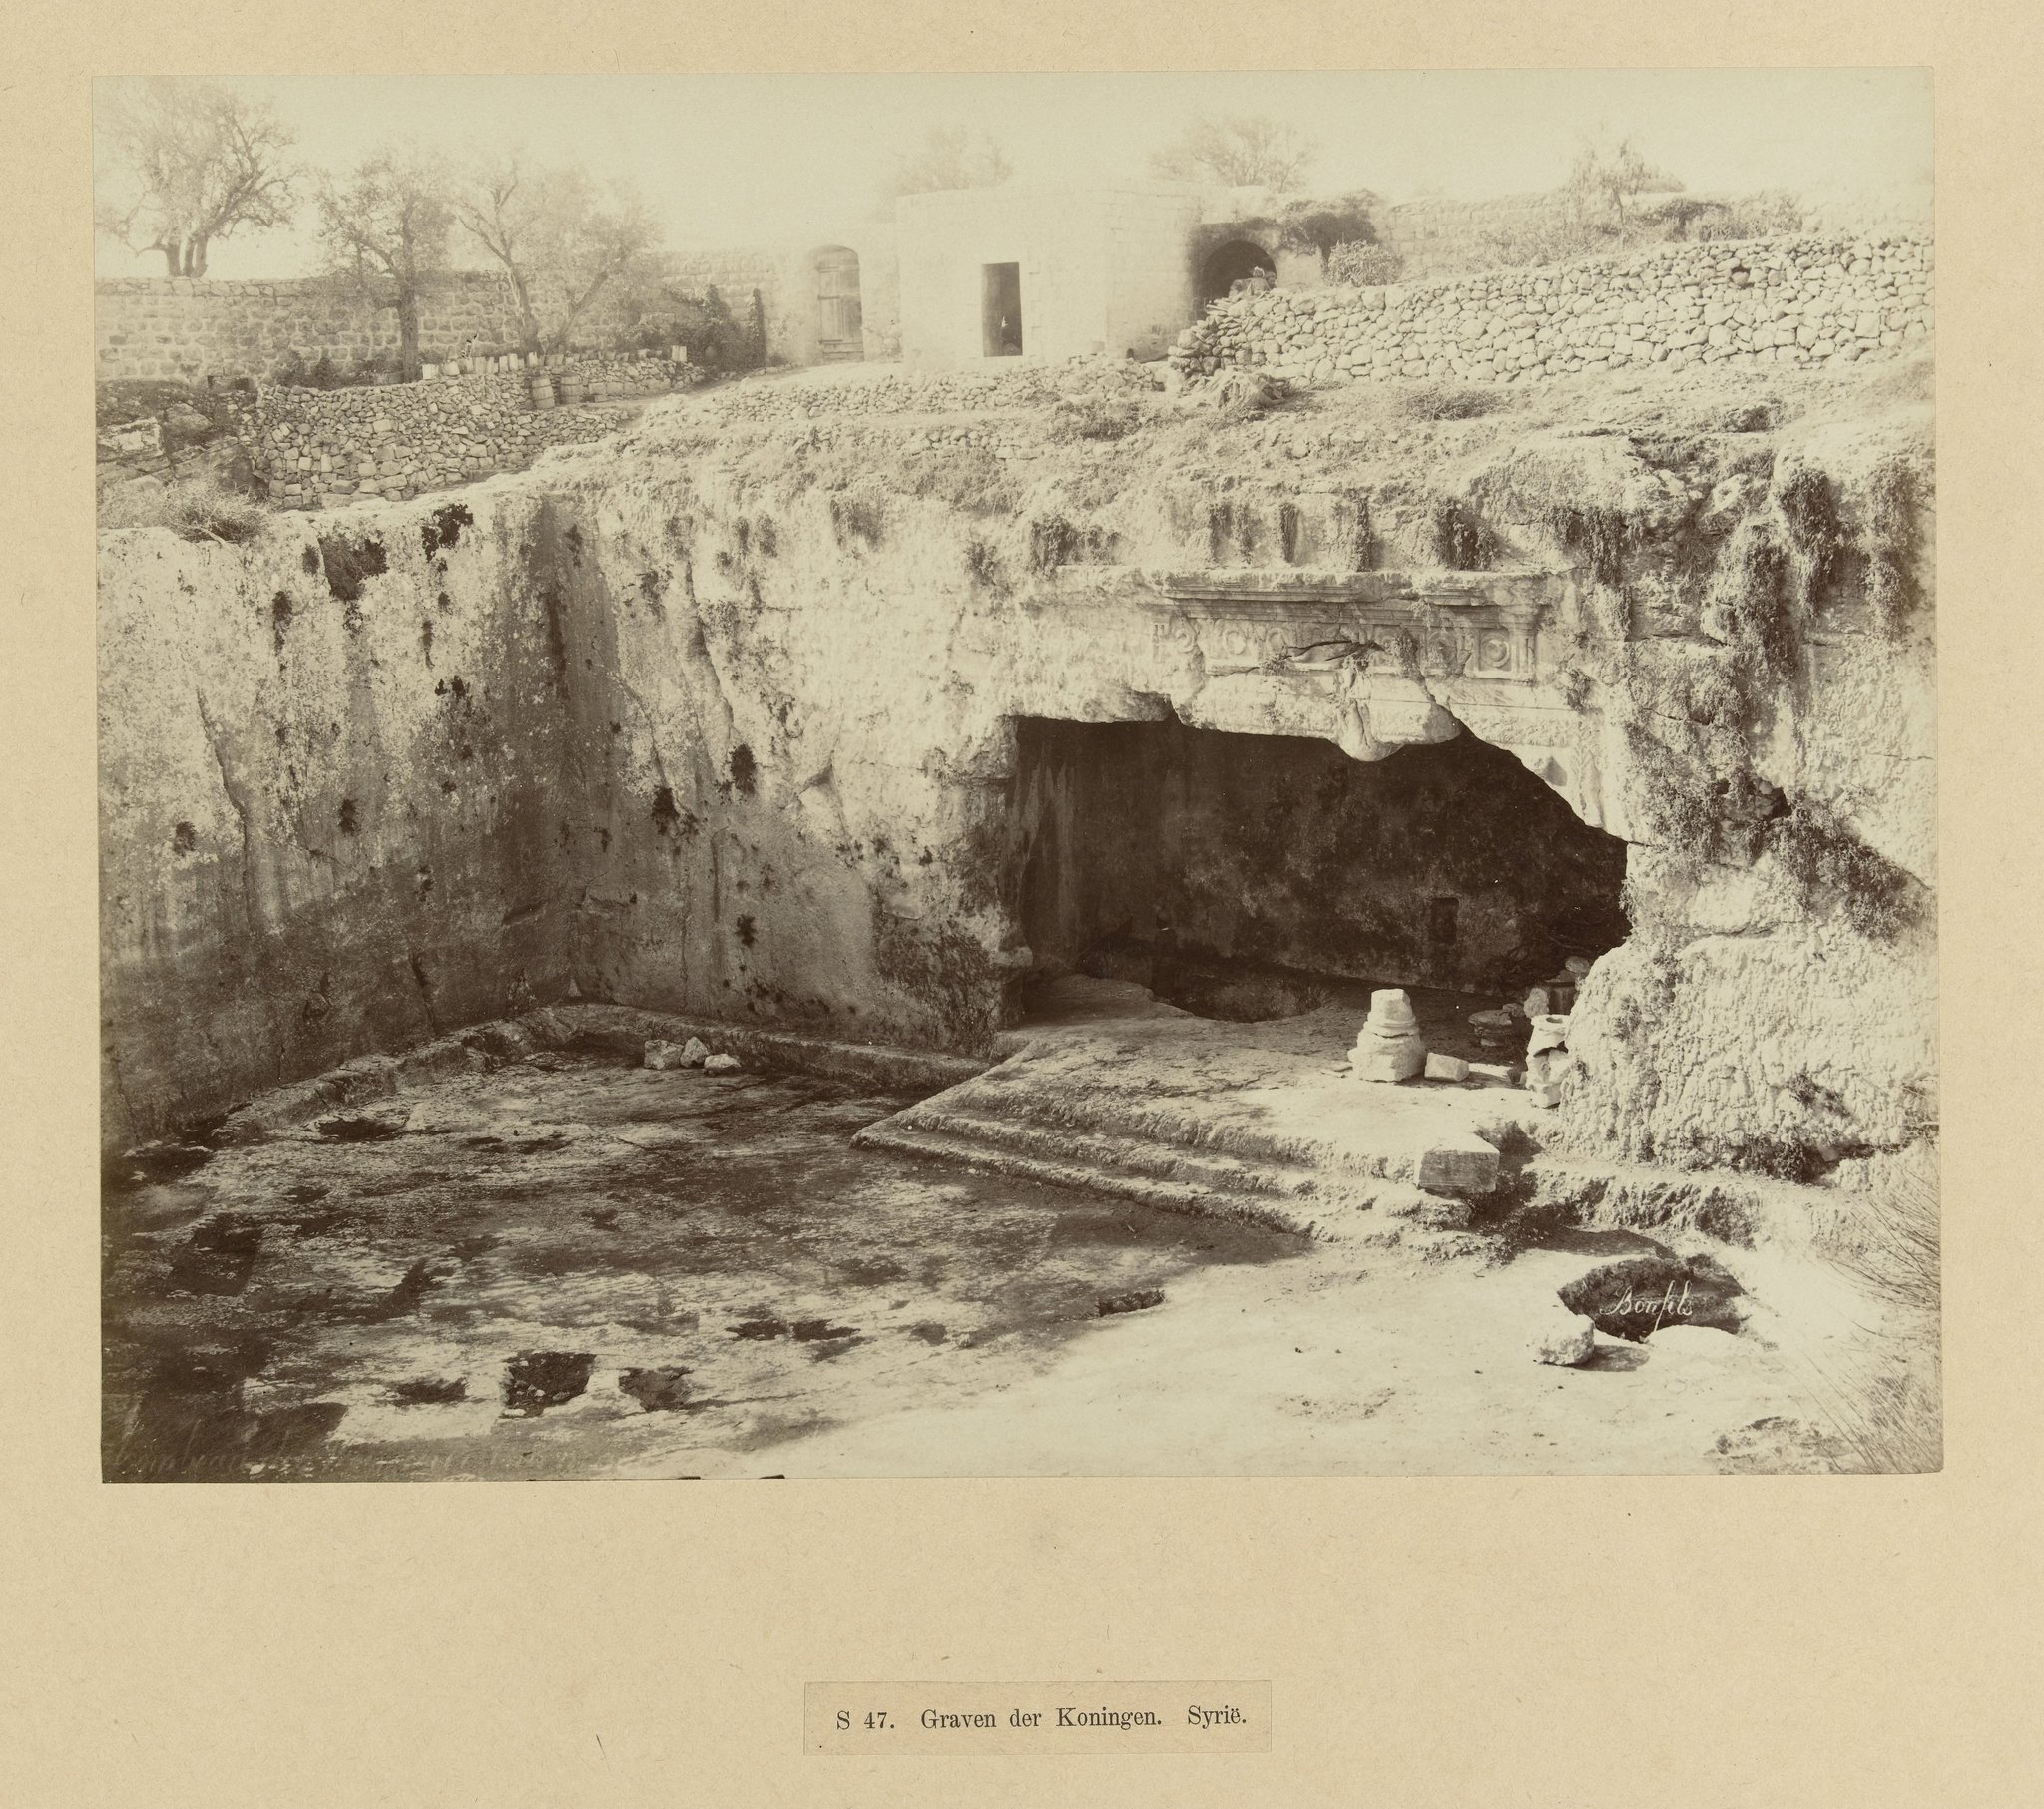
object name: photograph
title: Graven van de Koningen, nabij Jeruzalem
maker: félix bonfils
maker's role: fotograaf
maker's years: 1831-1885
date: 1867-1877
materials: cardboard, paper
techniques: albumen print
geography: jerusalem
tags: grave hollowed out of rock, cave, grotto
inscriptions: stamp: ‘Gemeentelijke bibliotheek/ Rotterdam’, inscription: ‘Tombeau [...]’, title: ‘S 467. Graven der Koningen. Syrië.’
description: Onderdeel van een groep door fotograaf Richard Polak op reis verzamelde foto’s. Deze foto is samen met andere op zijn reizen verzamelde foto's tentoongesteld bij de Rotterdamsche Kunstkring (1895), Arti en Amicitiae te Amsterdam (1897-1898?) en Societeit 't Collegie te Kampen (datum vooralsnog onbekend).